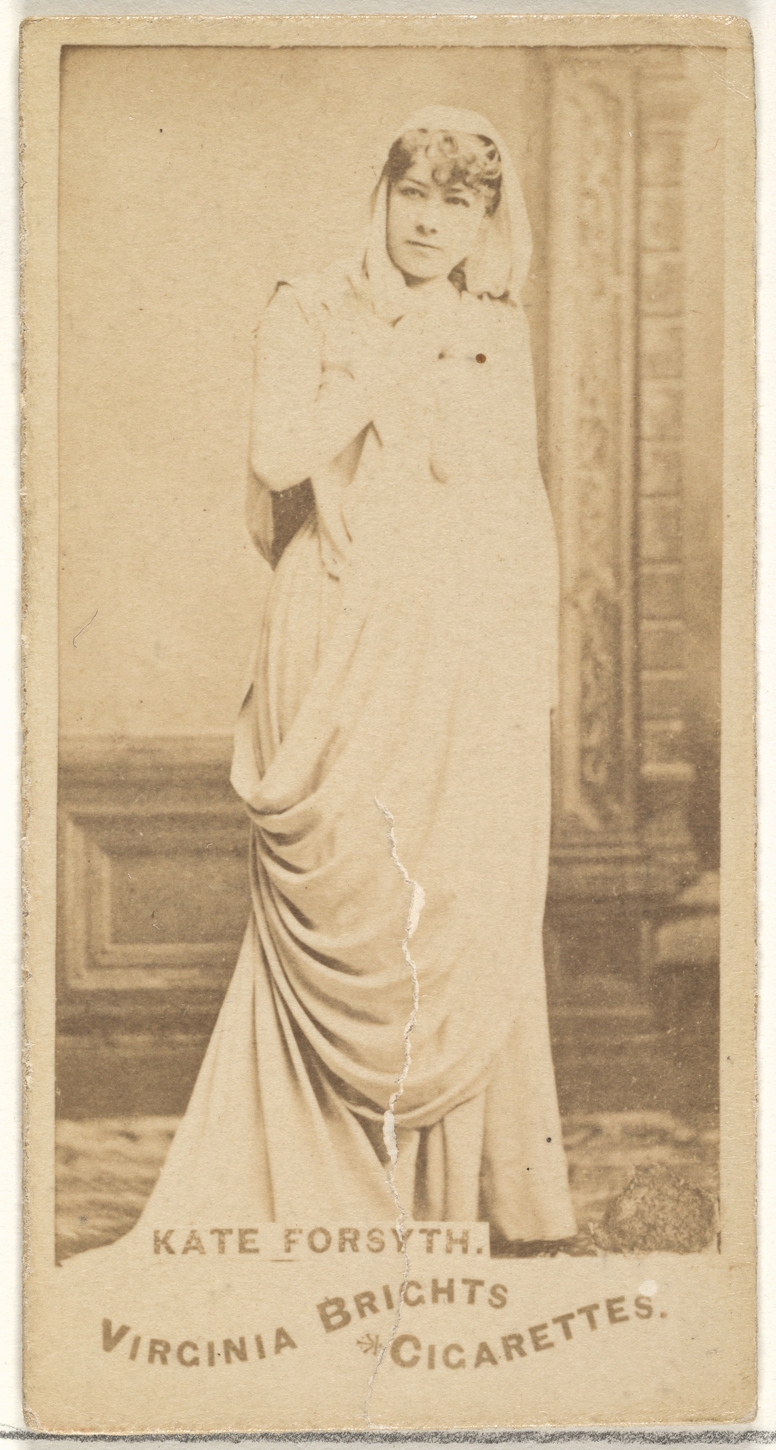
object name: photograph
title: Kate Forsyth, from the Actors and Actresses series (N45, Type 1) for Virginia Brights Cigarettes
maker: allen & ginter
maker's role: publisher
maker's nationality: american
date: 1888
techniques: albumen silver print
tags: portraits,women,actresses